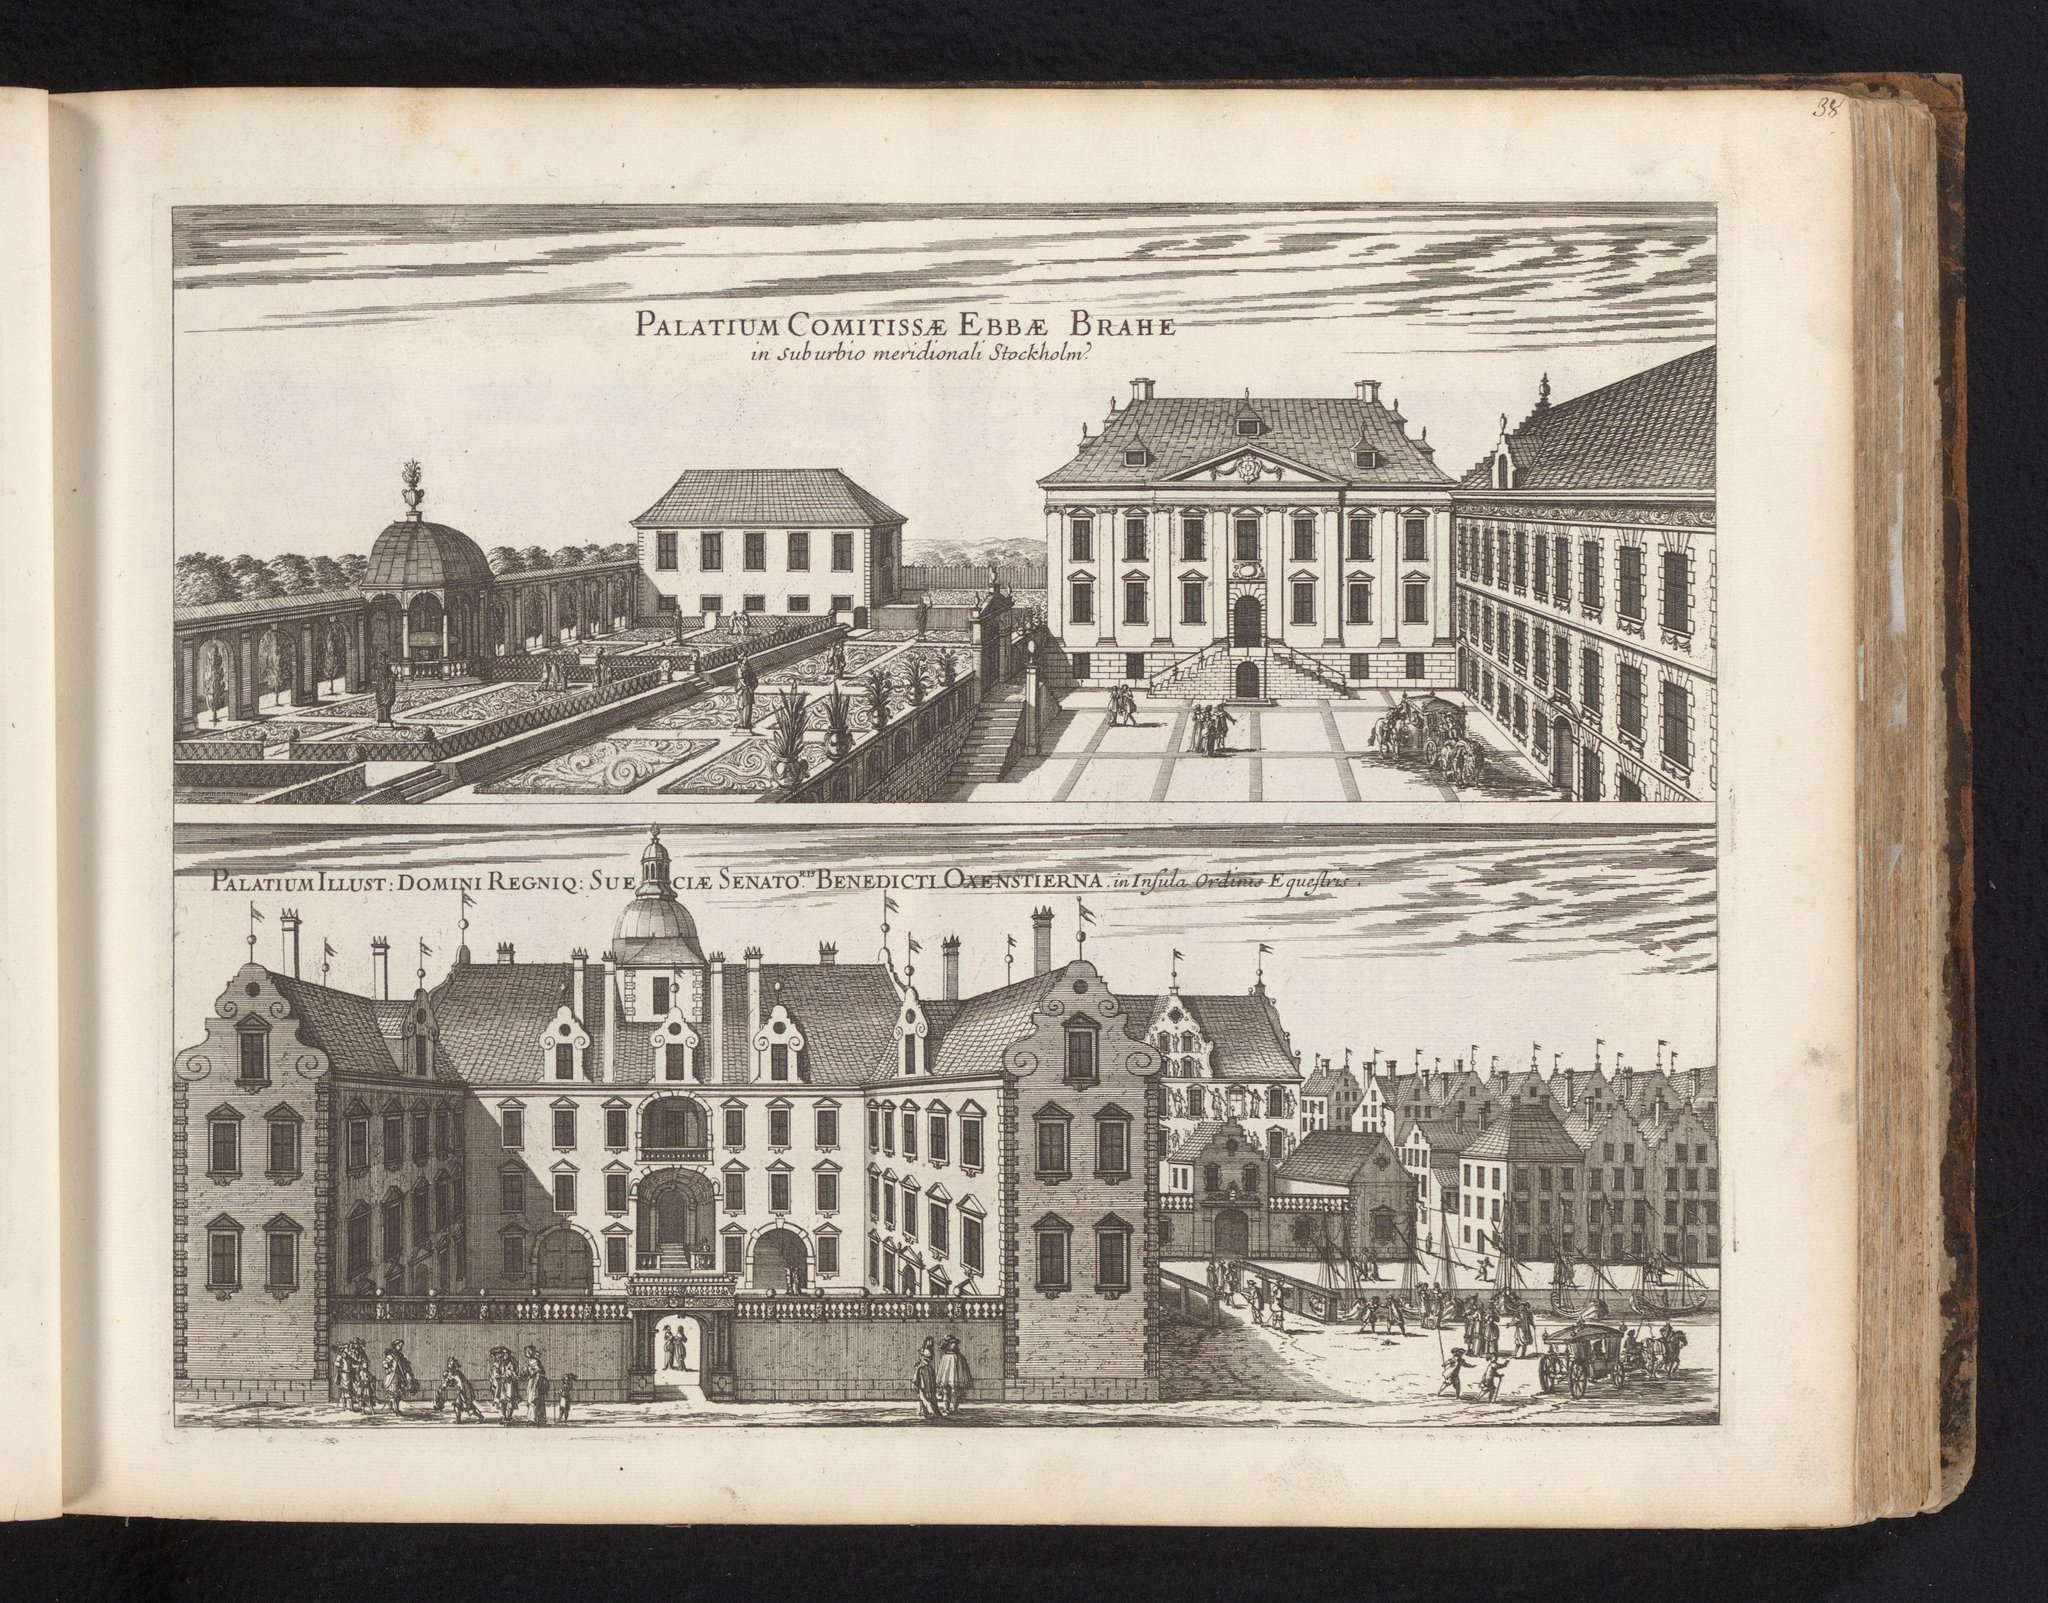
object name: print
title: Suecia Antiqua et Hodierna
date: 1670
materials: paper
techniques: etching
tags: palace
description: Kungliga Biblioteket, 'Suecia': http://www.kb.se/samlingarna/Kartor-bilder/Suecia-antiqua/ (geraadpleegd november 2016).